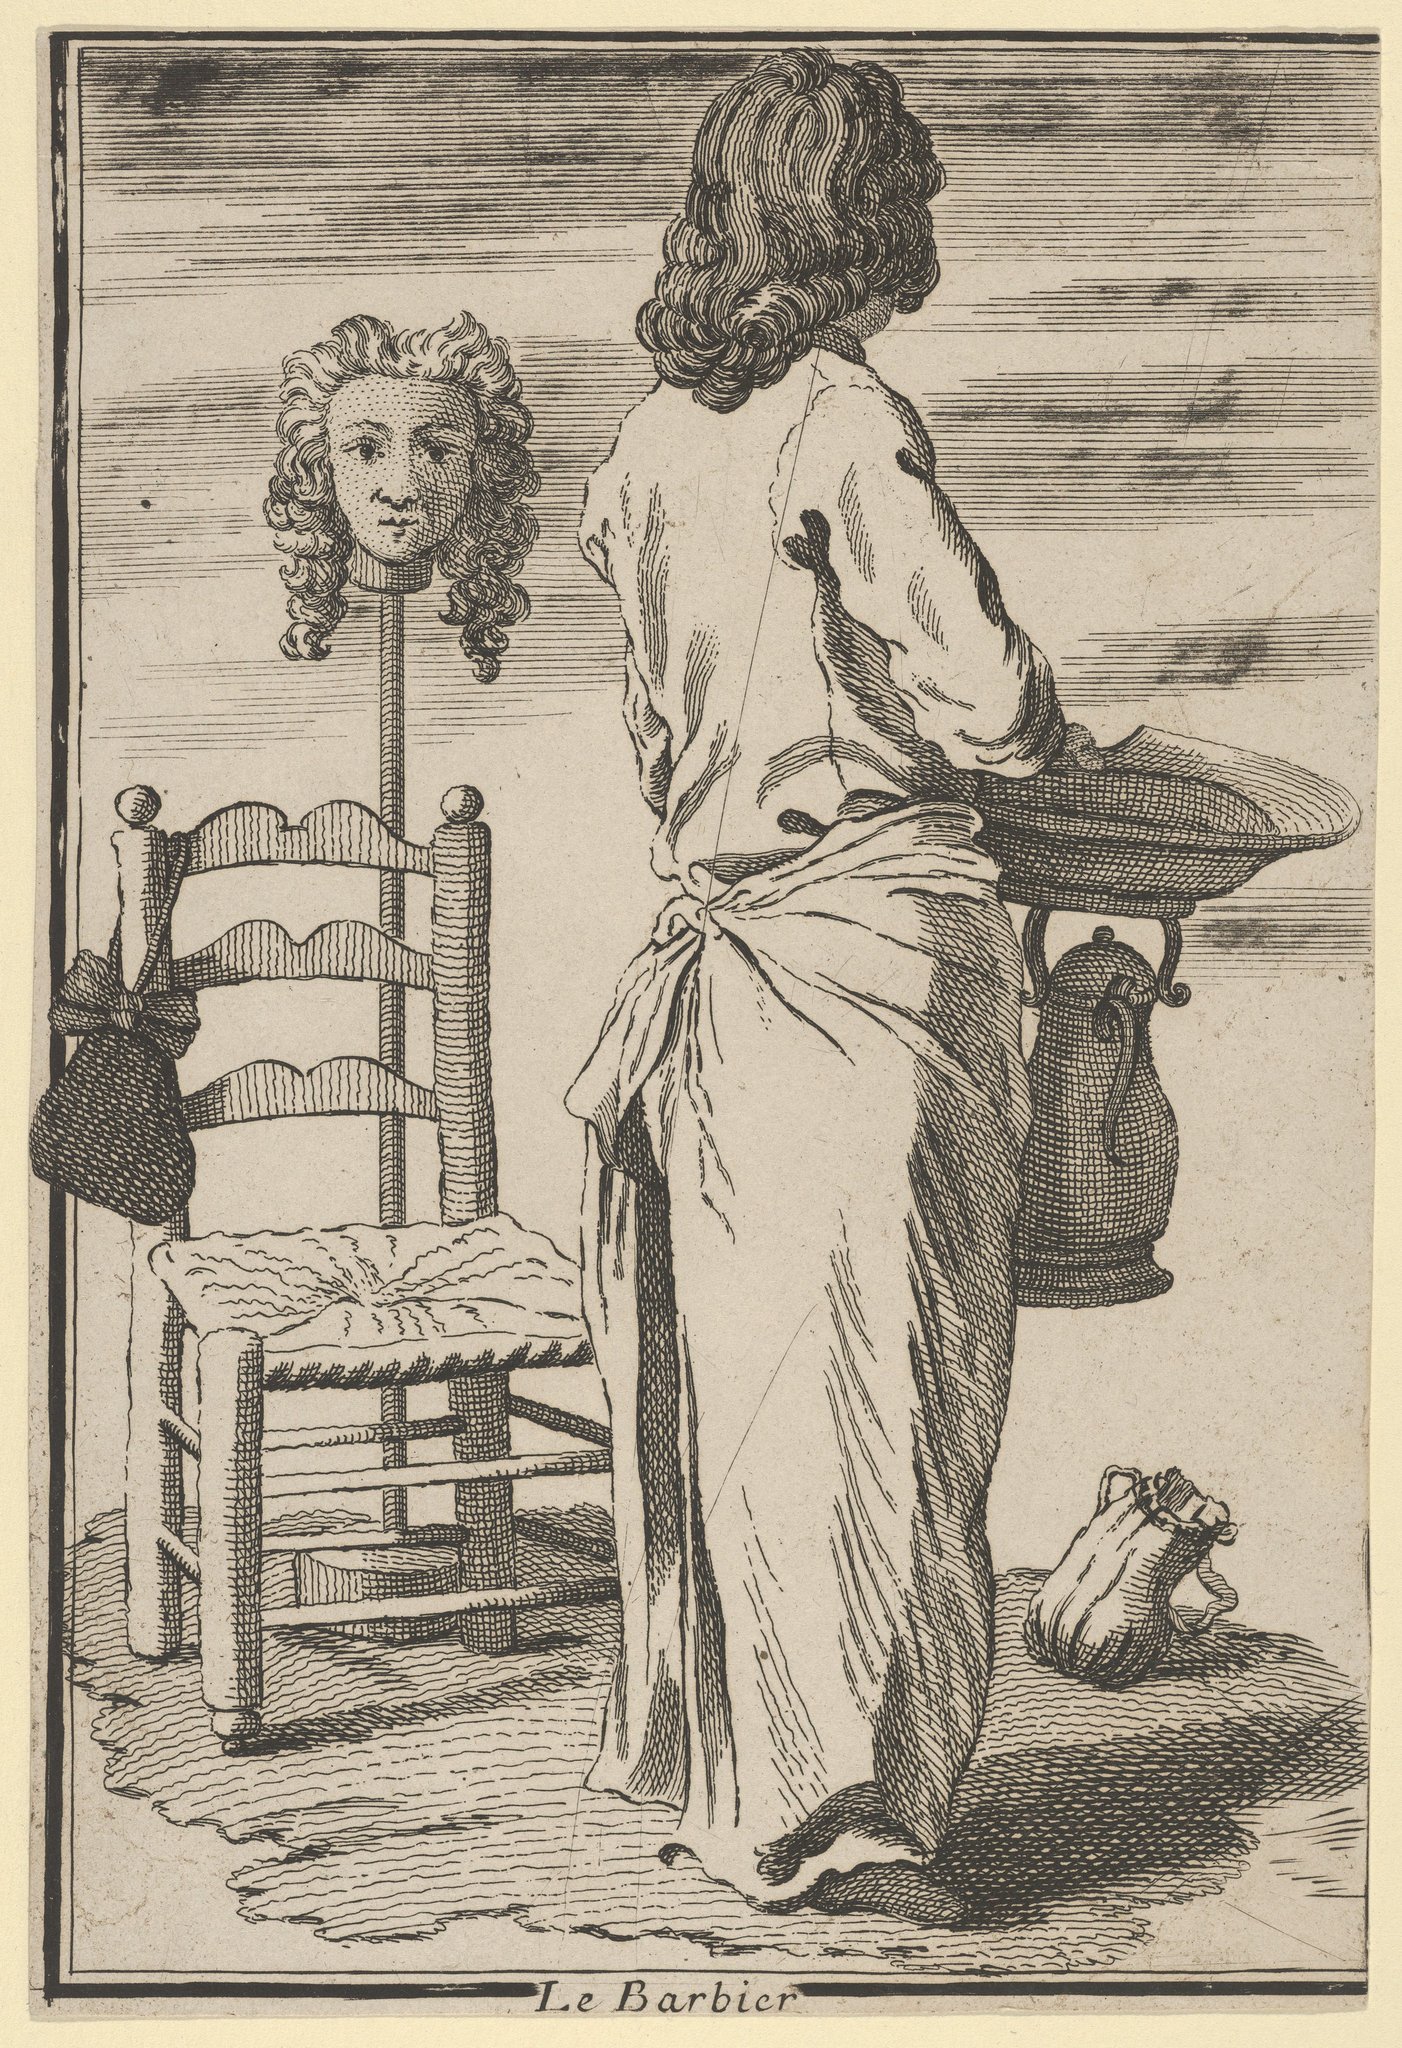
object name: print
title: The Barber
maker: anonymous, french, 18th century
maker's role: artist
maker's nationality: french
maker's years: 1700-1800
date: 1742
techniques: etching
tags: heads,men,profiles,chairs